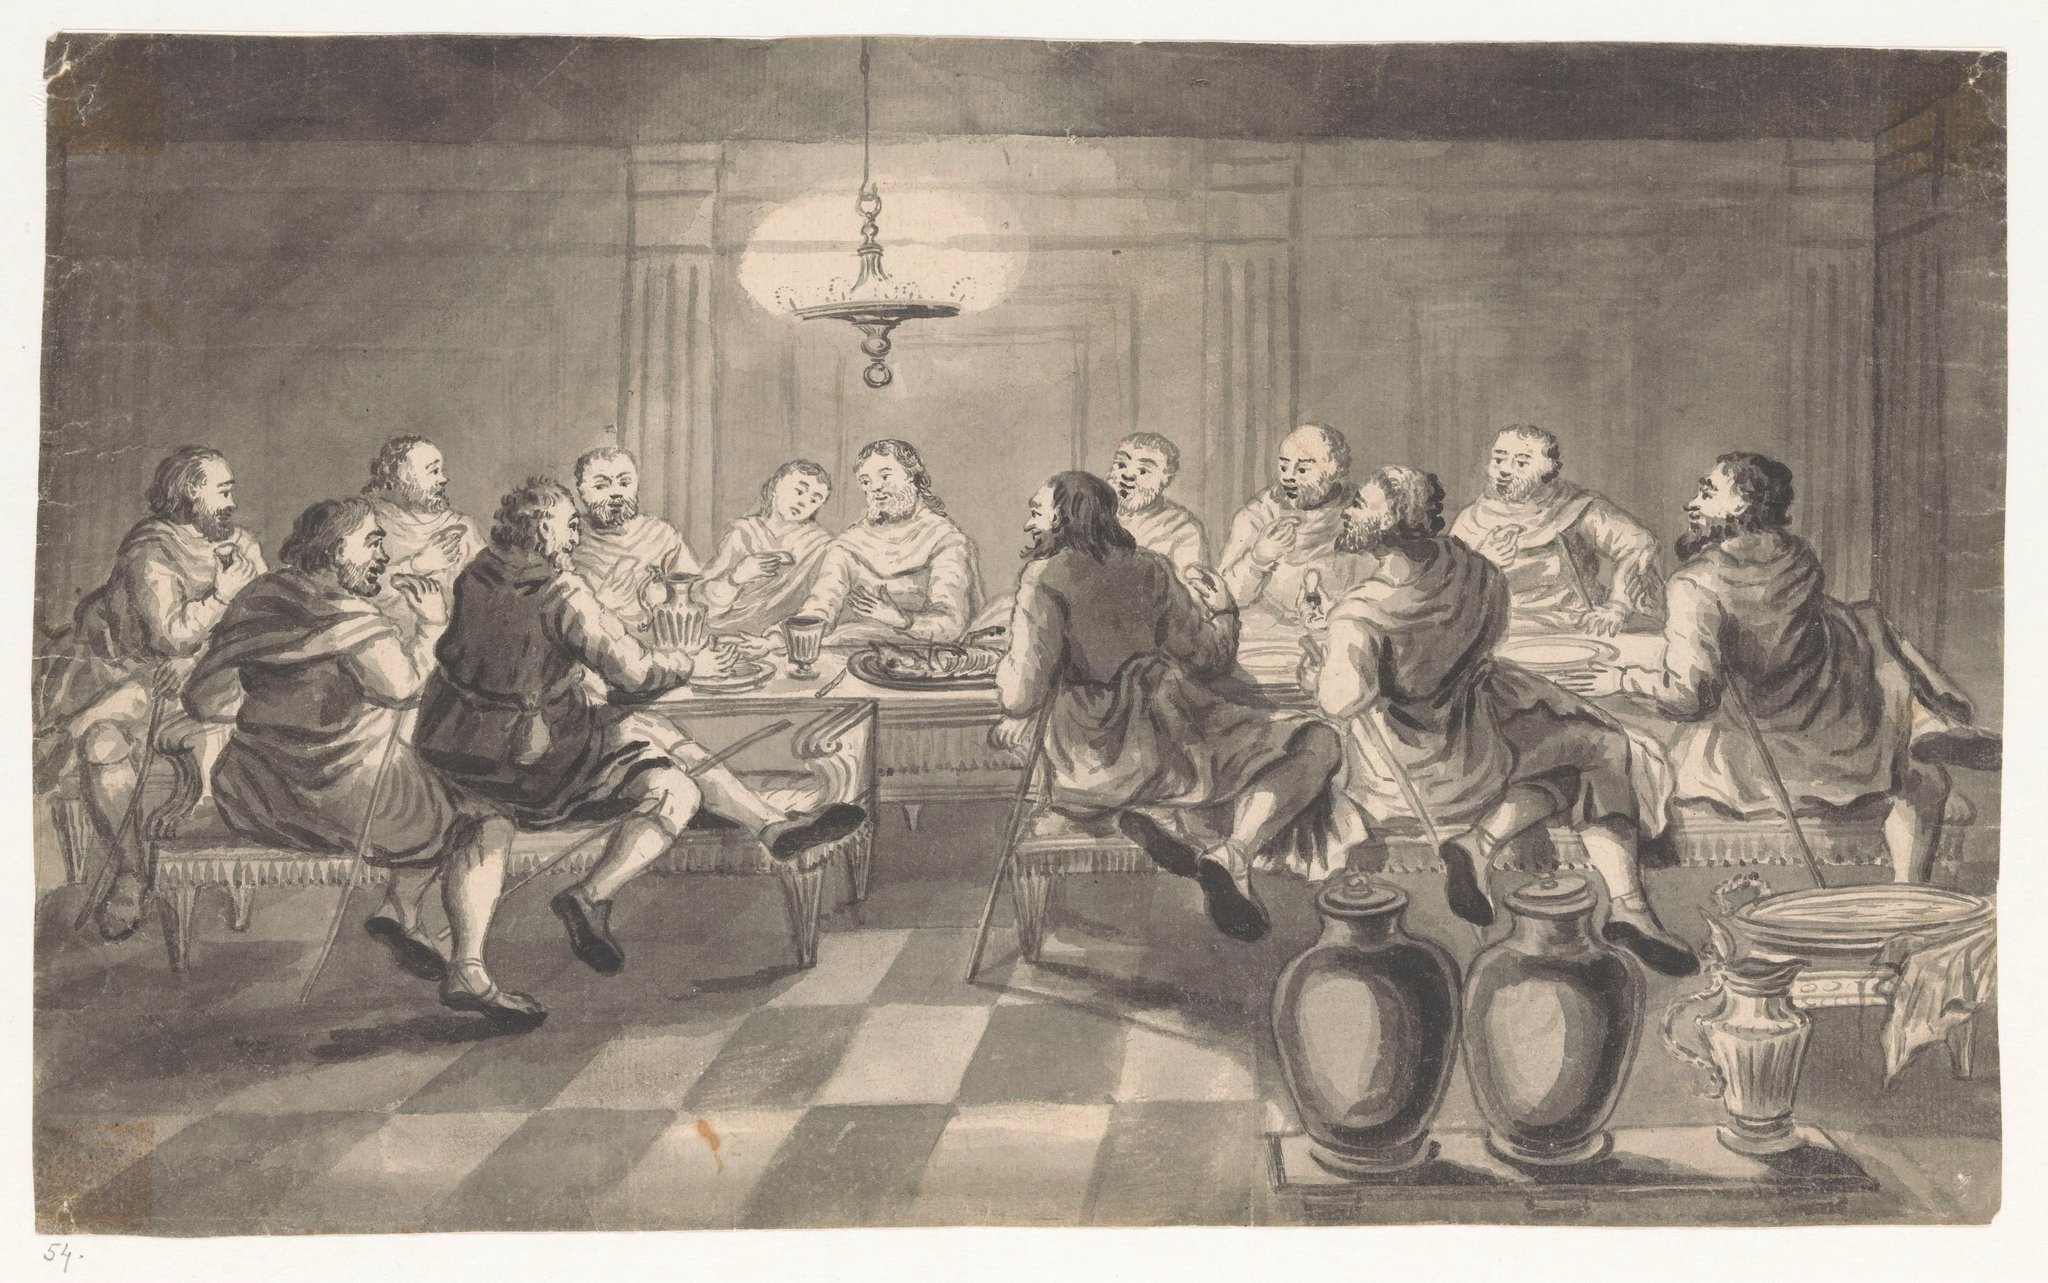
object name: drawing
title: Laatste Avondmaal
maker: jan brandes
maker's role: draughtsman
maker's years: 1743-1808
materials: ink, paper, pencil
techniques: brush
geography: skälsebo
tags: last supper (in general) (matthew 26:21-35; mark 14:18-31; luke 22:3, 22:15-23; john 13:21-38)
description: Het Laatste Avondmaal. Christus aan tafel omringd door de apostelen.